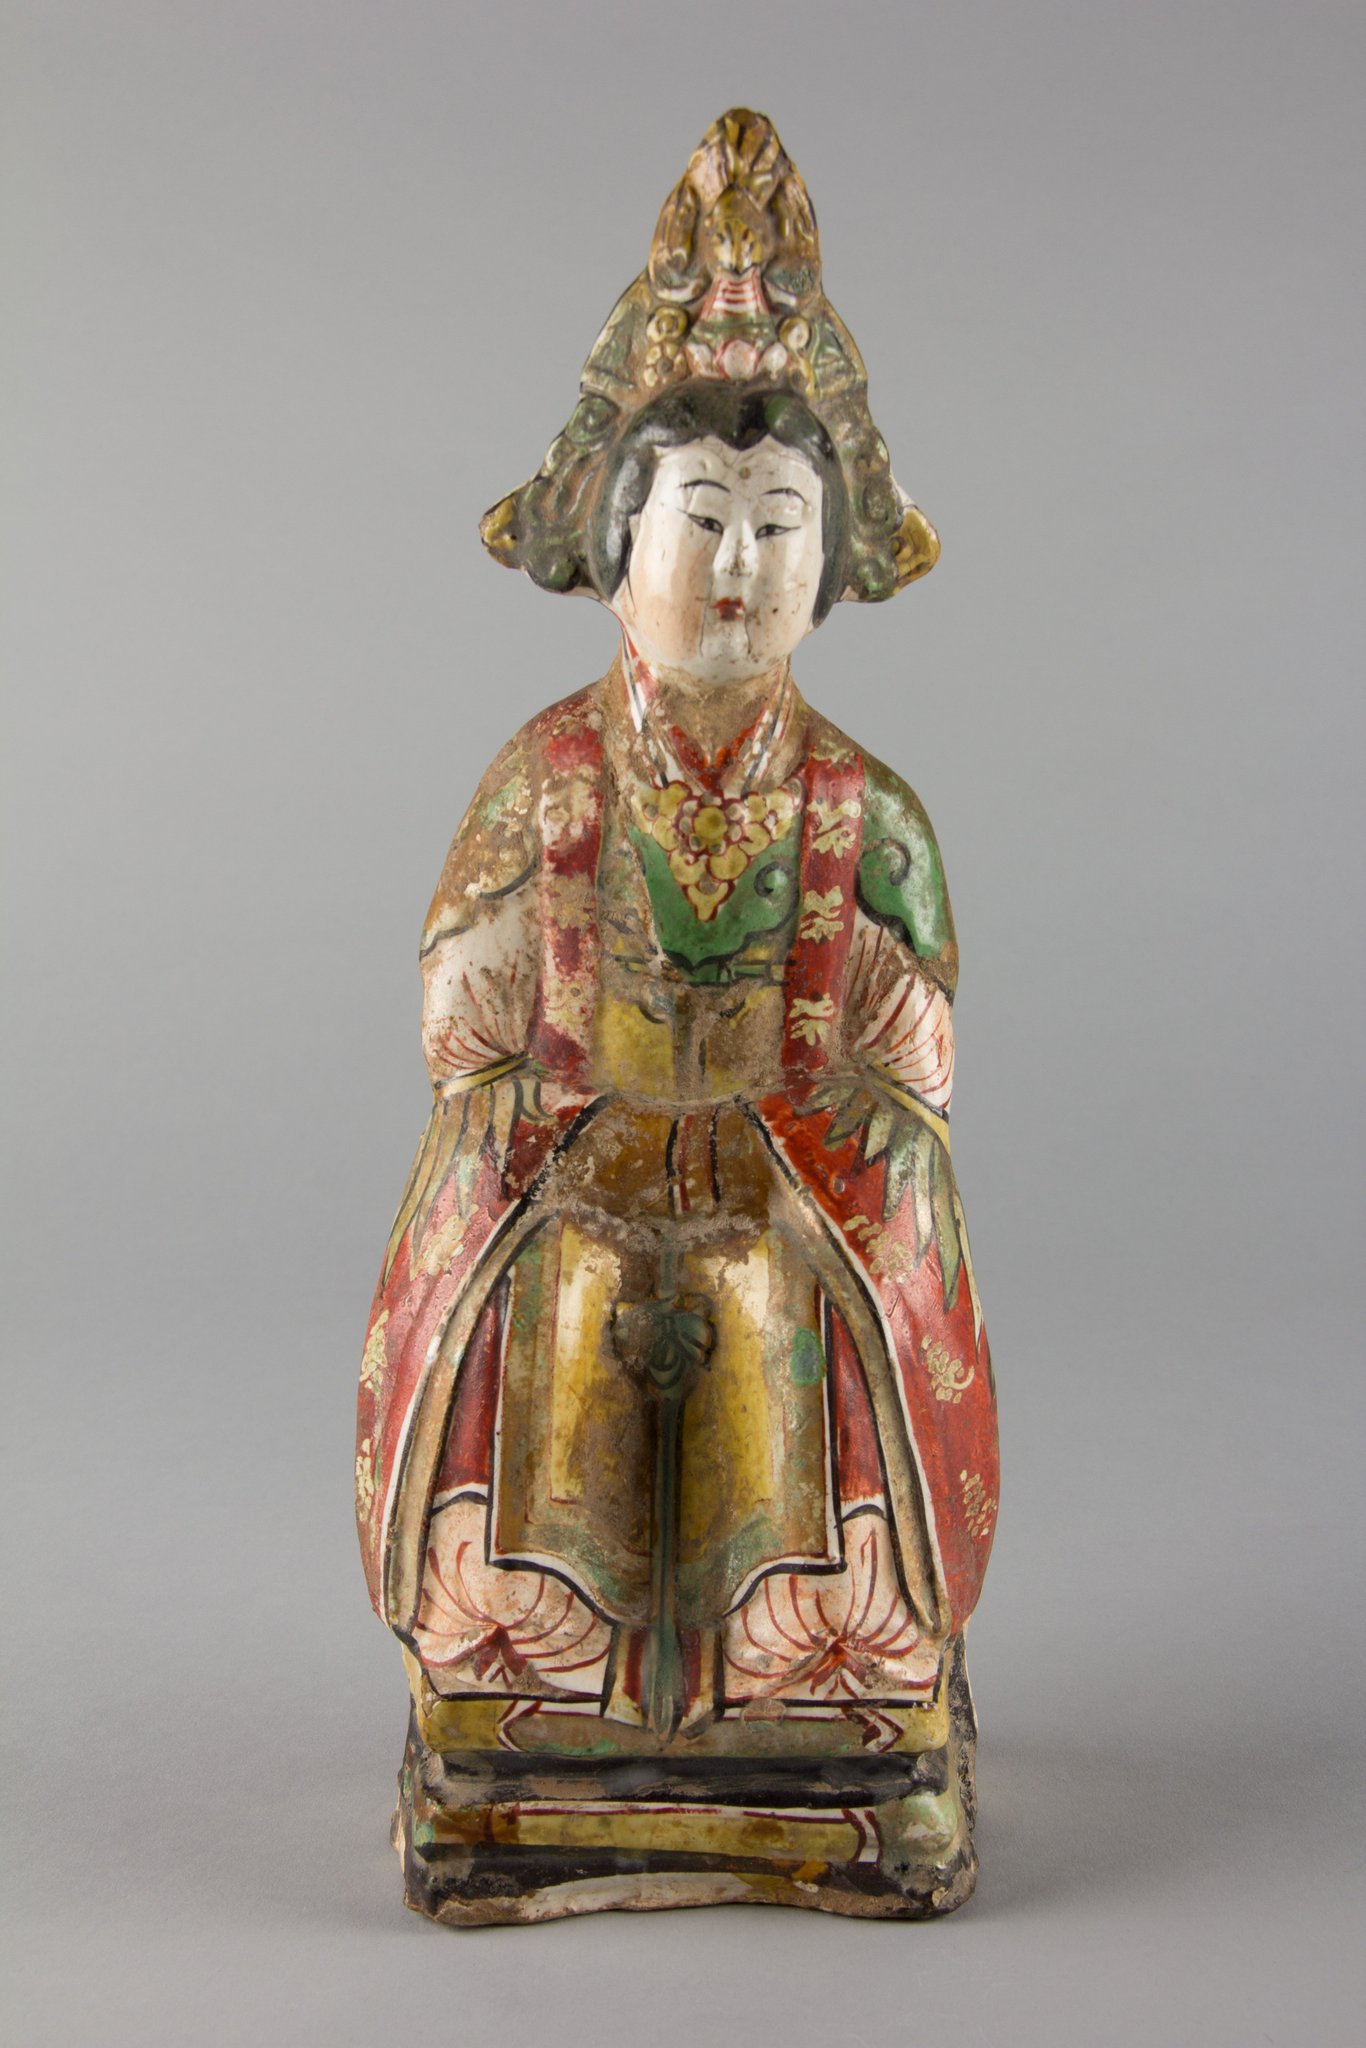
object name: figure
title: Figure of a sitting woman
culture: chinese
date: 1101-1300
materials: enamel, stoneware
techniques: overglaze, painting, polychrome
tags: women